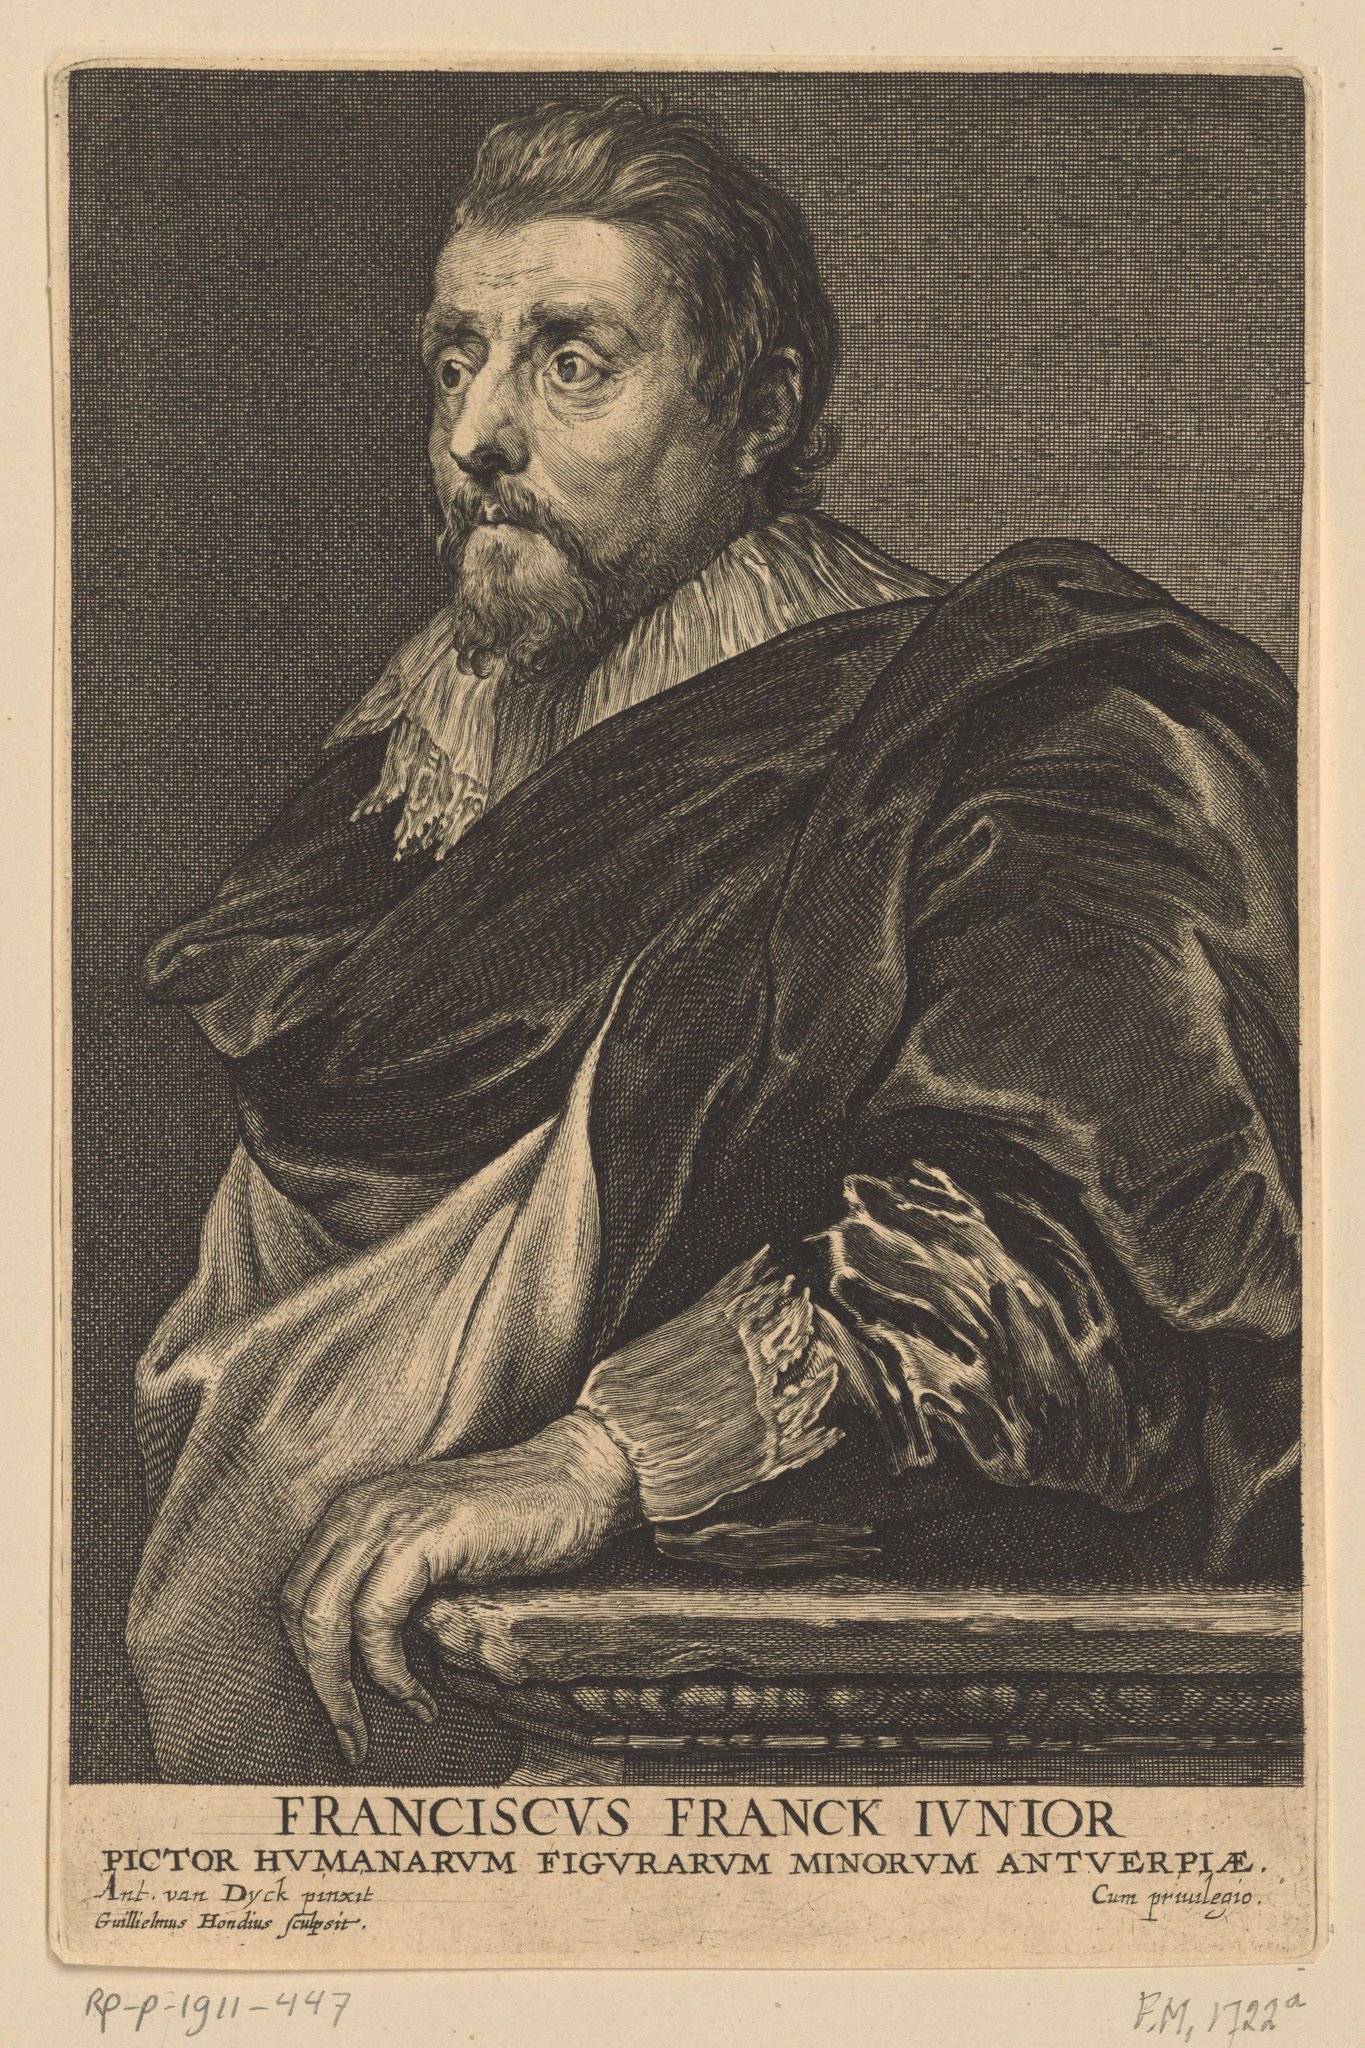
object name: book illustration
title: Portret van Frans Francken (II)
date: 1645-1646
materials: paper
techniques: engraving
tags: antwerp, draughtsman, frans francken (ii), historical persons, portrait, self-portrait of painter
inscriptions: collector's mark: Lugt 2228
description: Prent in deze staat gebruikt in: Iconographie ou Vies des Hommes Illustres du XVII. Siecle (...). 2 dln. Amsterdam: Johann Caspar Arkstee, Leipzig: Henricus Merkus, 1759, dl. 2, p. 88. Prent is ontworpen voor de serie 'Iconographie' samengesteld door Anthony van Dyck en uitgegeven in 1645-1646.